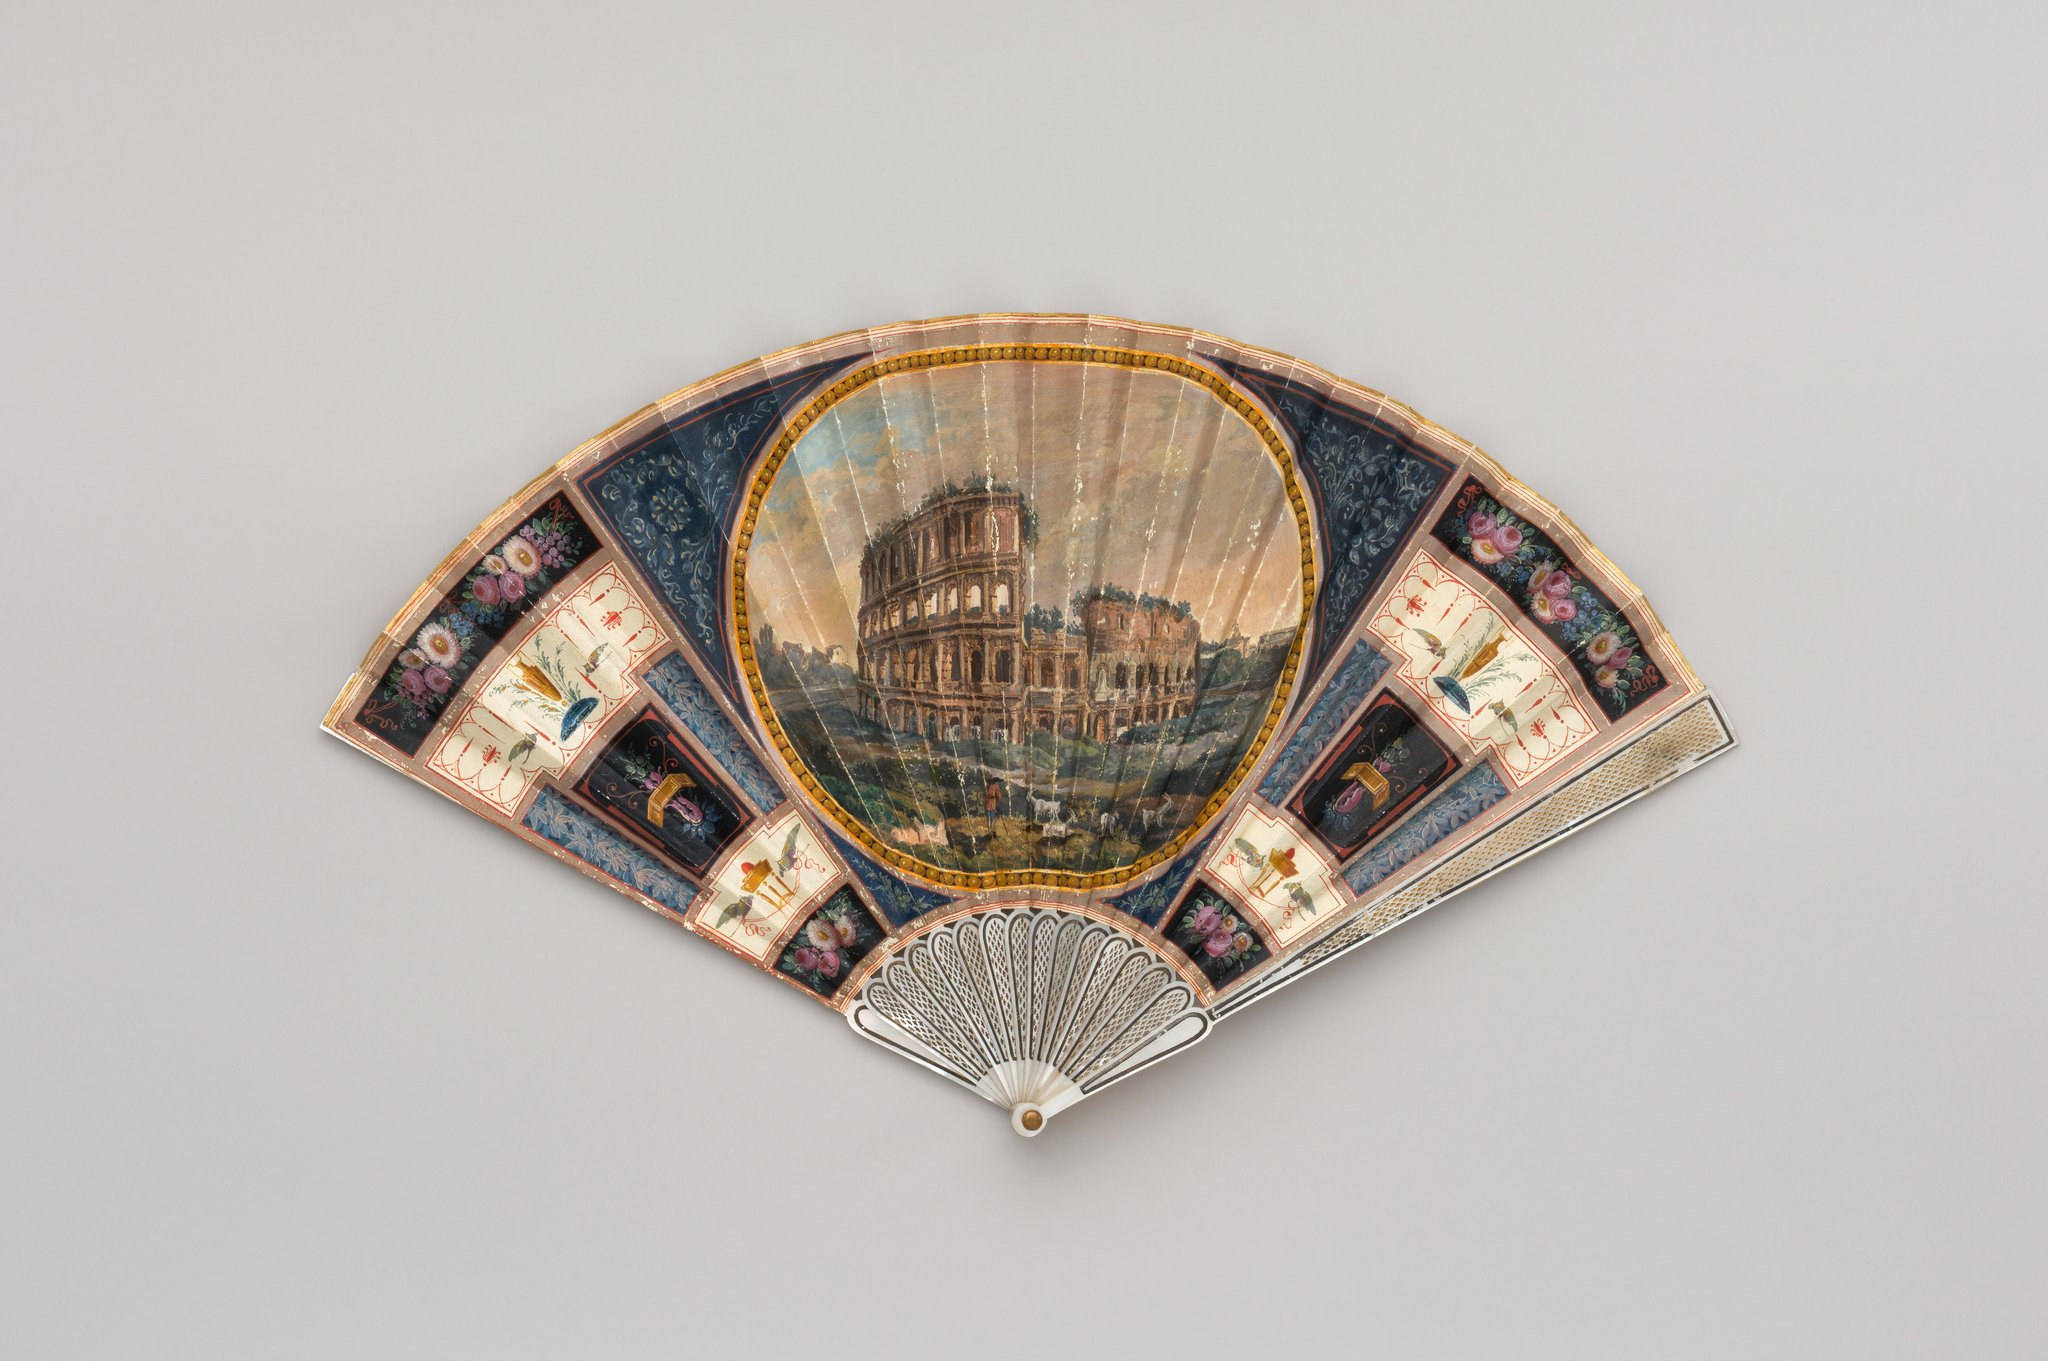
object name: fan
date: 1801-1833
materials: mother of pearl, parchment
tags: ruins